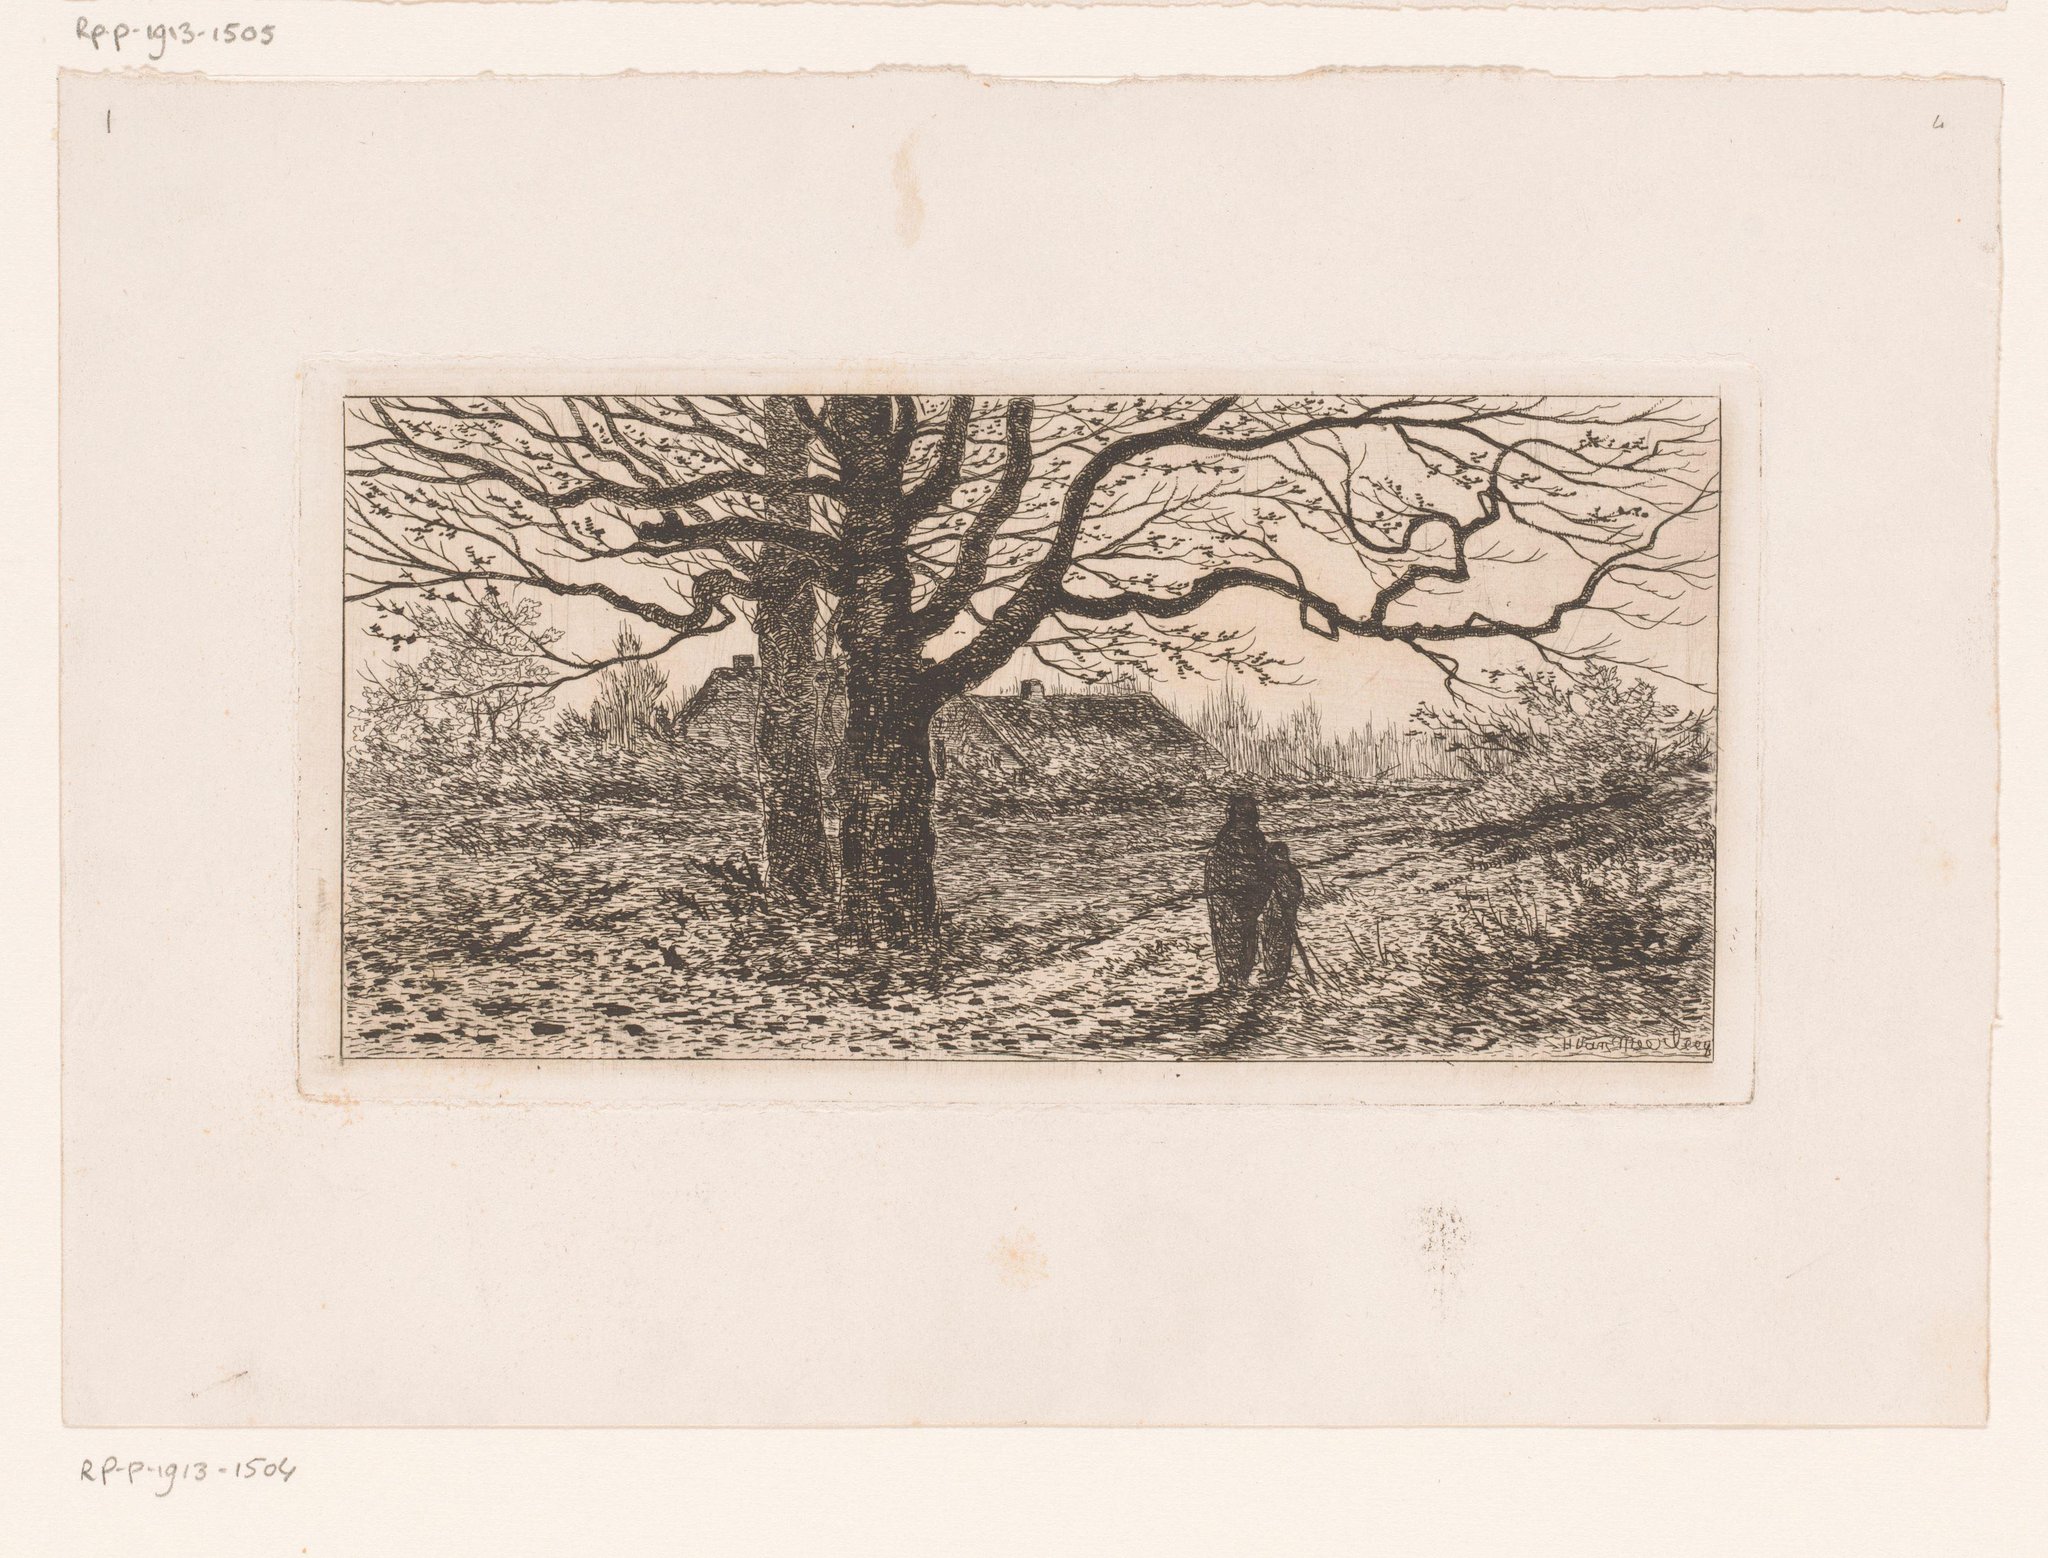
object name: print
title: Landschap met twee figuren bij een boerderij en twee grote bomen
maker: h. van meerbeeck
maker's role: print maker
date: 1850-1913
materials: paper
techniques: etching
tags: trees, farm or solitary house in landscape (+ city(-scape) with figures, staffage)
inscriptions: collector's mark: Lugt 2228